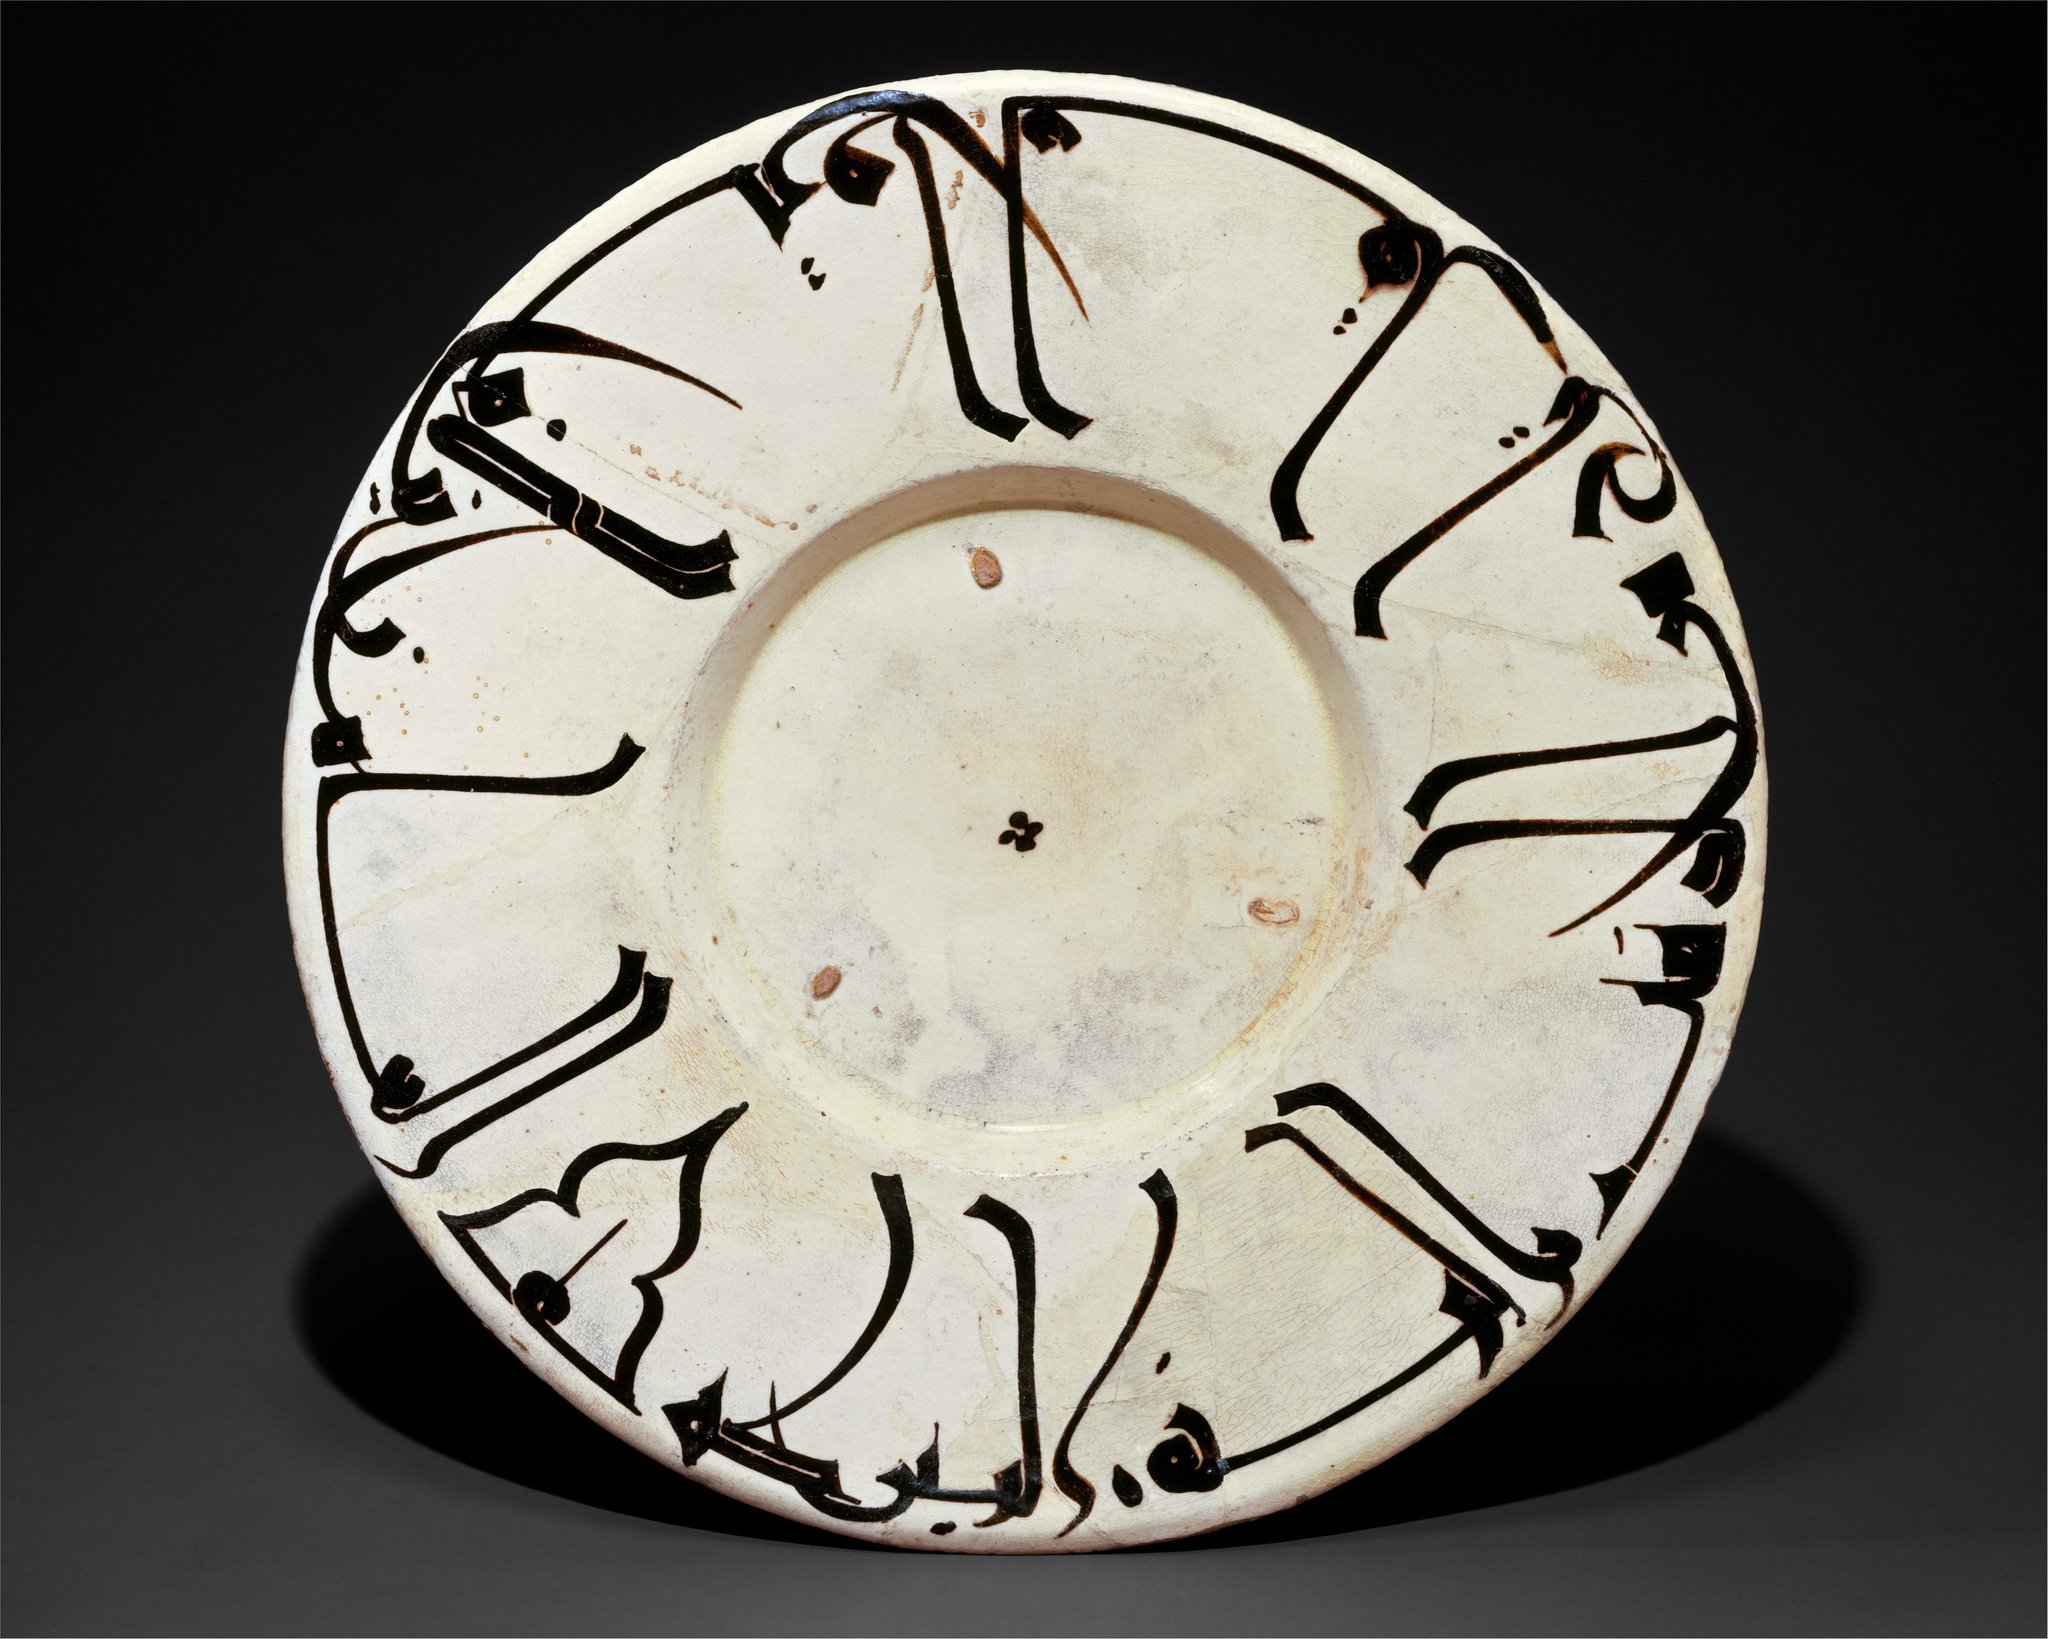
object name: plate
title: Plate with Calligraphic Decoration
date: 901-1000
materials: earthenware, glaze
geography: iran